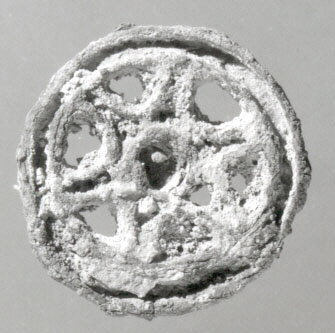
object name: stamp seal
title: Compartmented stamp seal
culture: bactria-margiana archaeological complex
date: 2333-1668 BCE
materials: copper alloy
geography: bactria-margiana